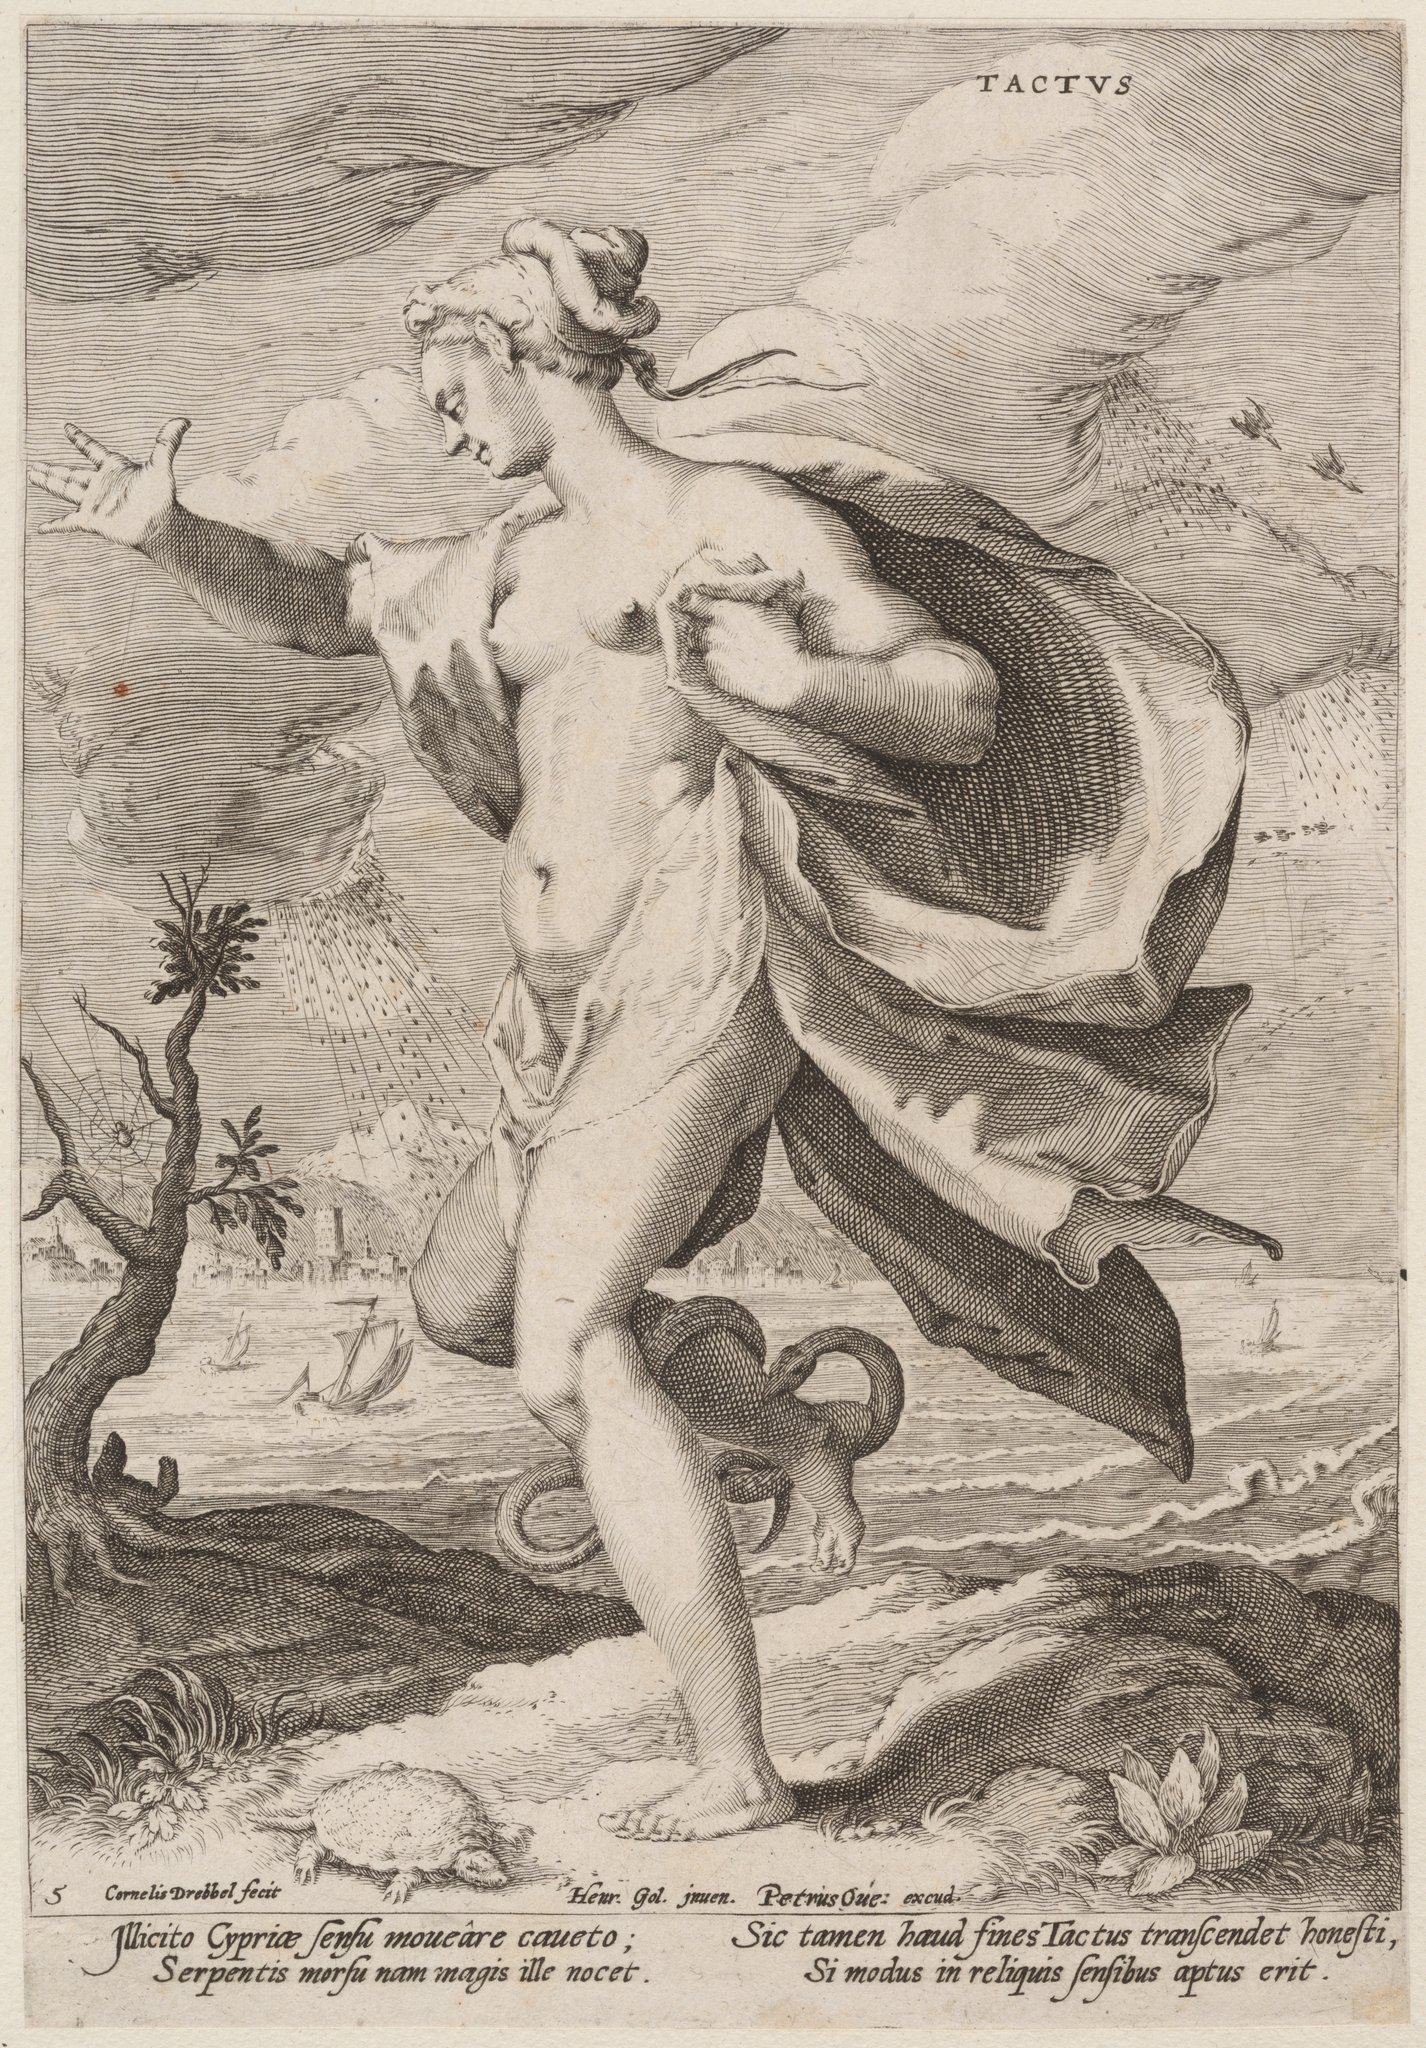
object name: print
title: Touch, from the Five Senses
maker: cornelis drebbel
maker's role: artist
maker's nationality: netherlandish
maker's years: 1572-1633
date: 1596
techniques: engraving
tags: female nudes,snakes,turtles